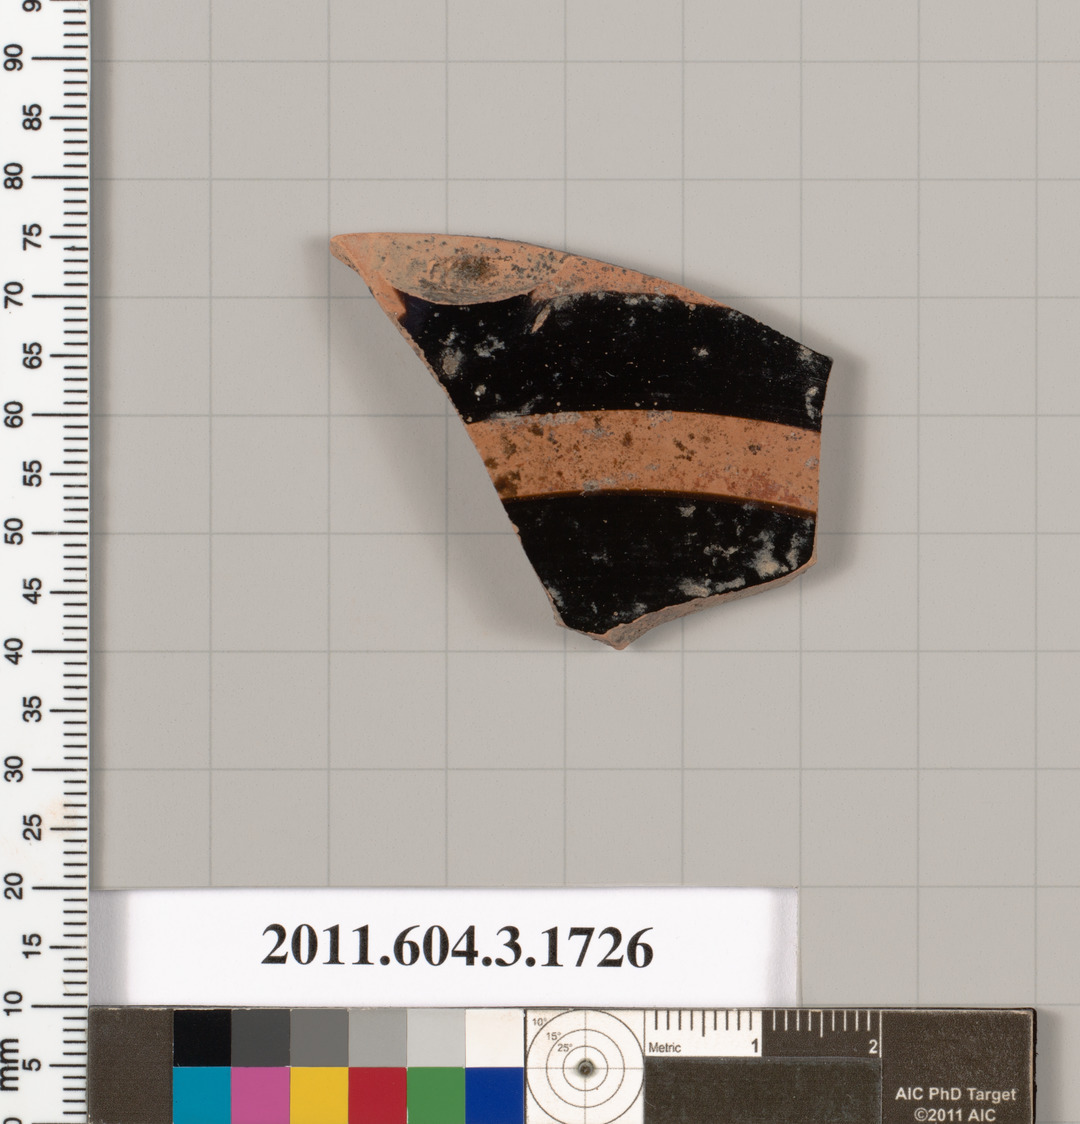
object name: kylix fragment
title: Terracotta fragment of a kylix: Band or lip cup (drinking cup)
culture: greek, attic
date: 550-526 BCE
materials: terracotta